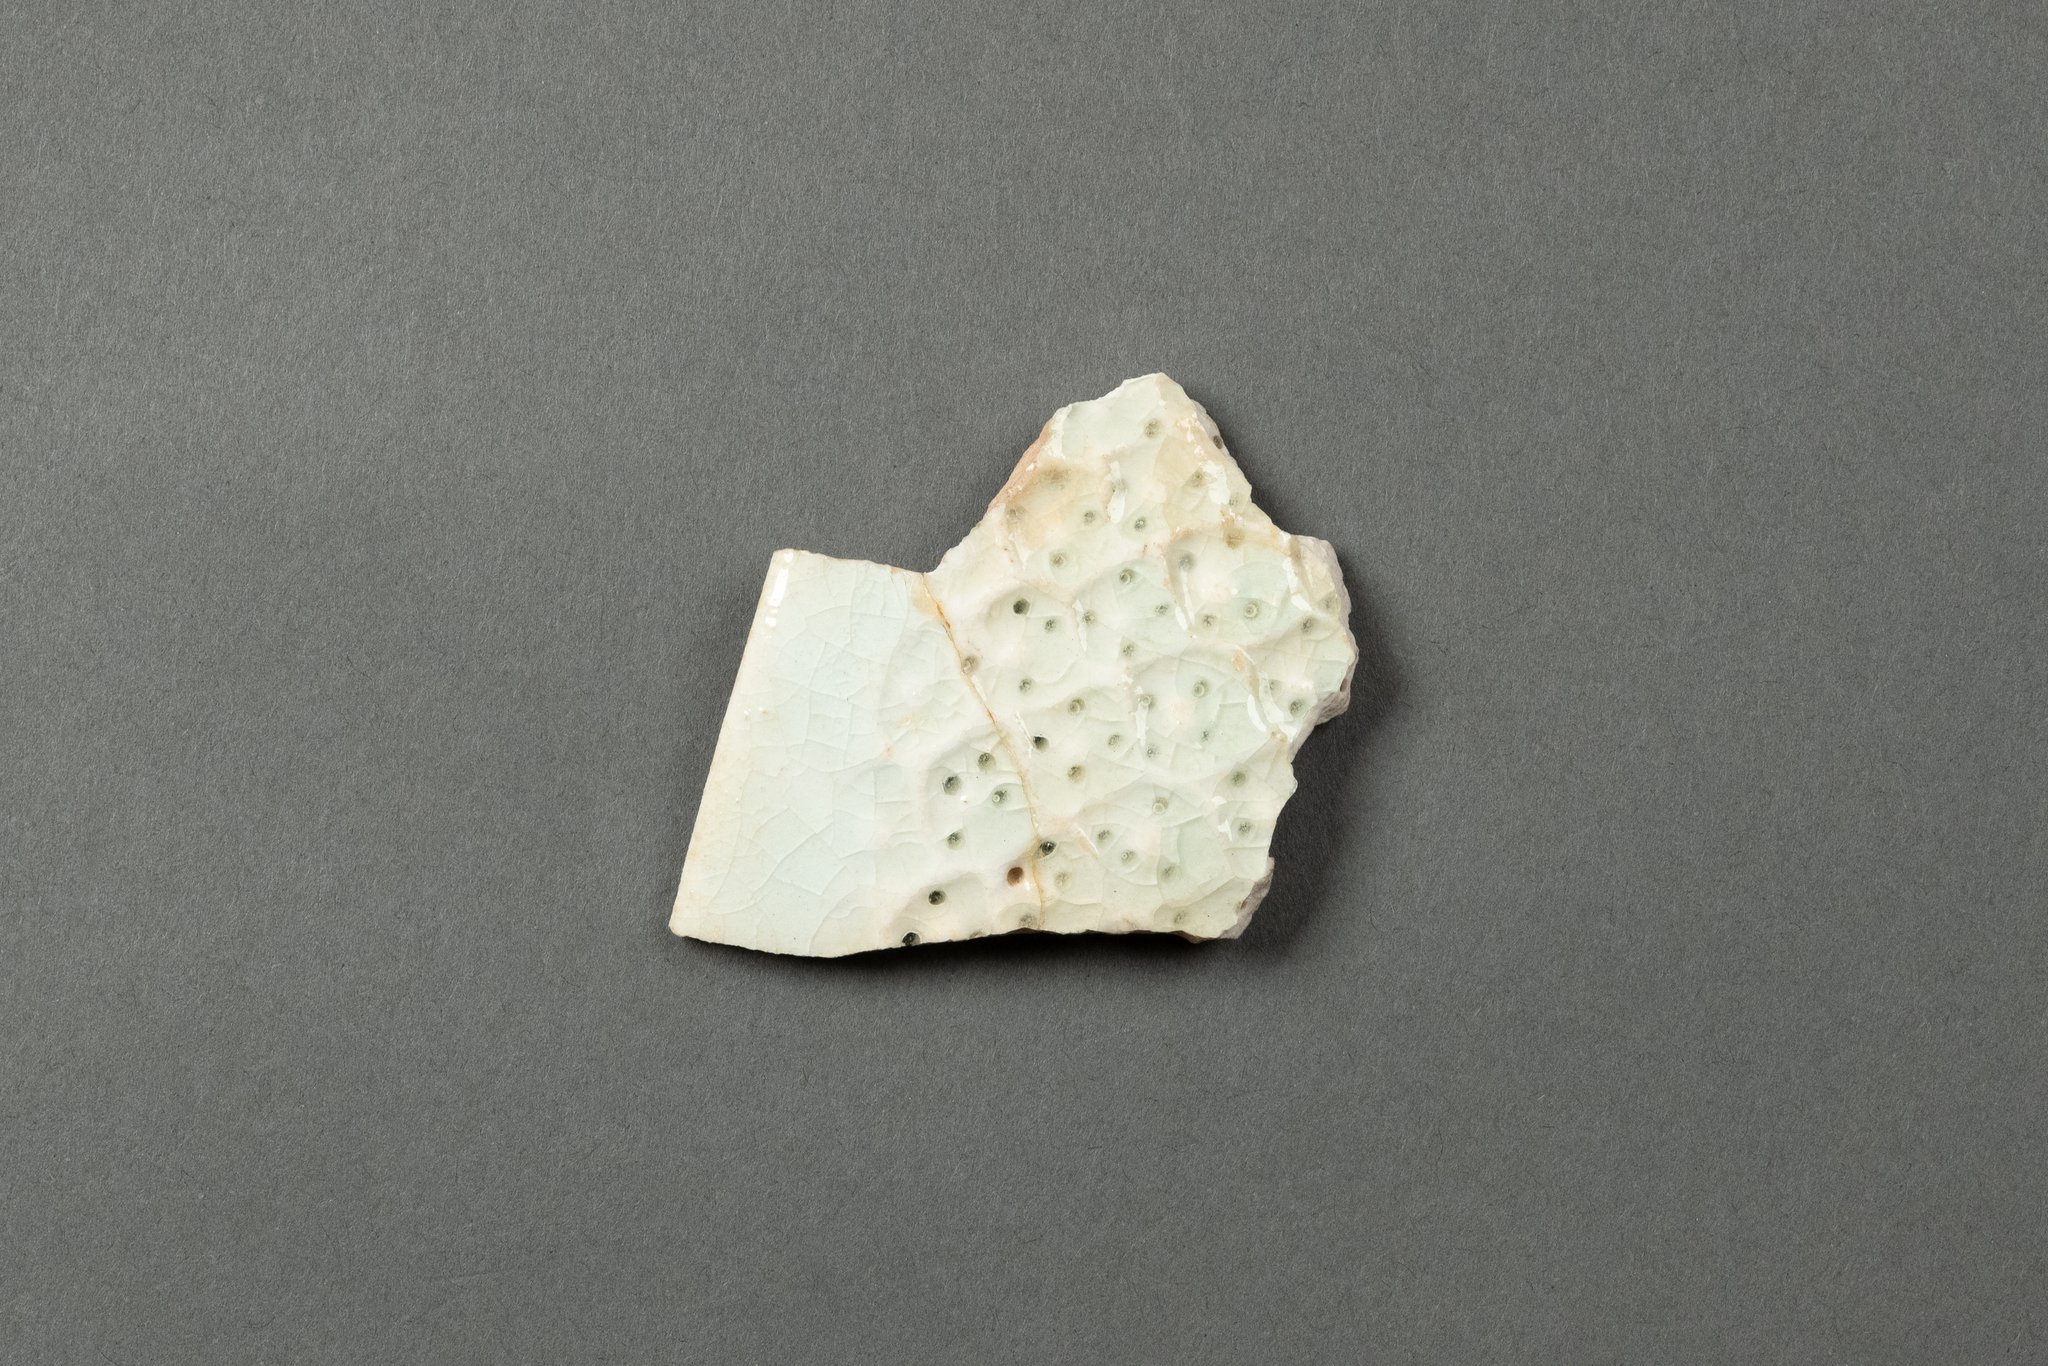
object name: fragment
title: Fragment of Bowl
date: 701-1200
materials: earthenware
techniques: glazing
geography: iran